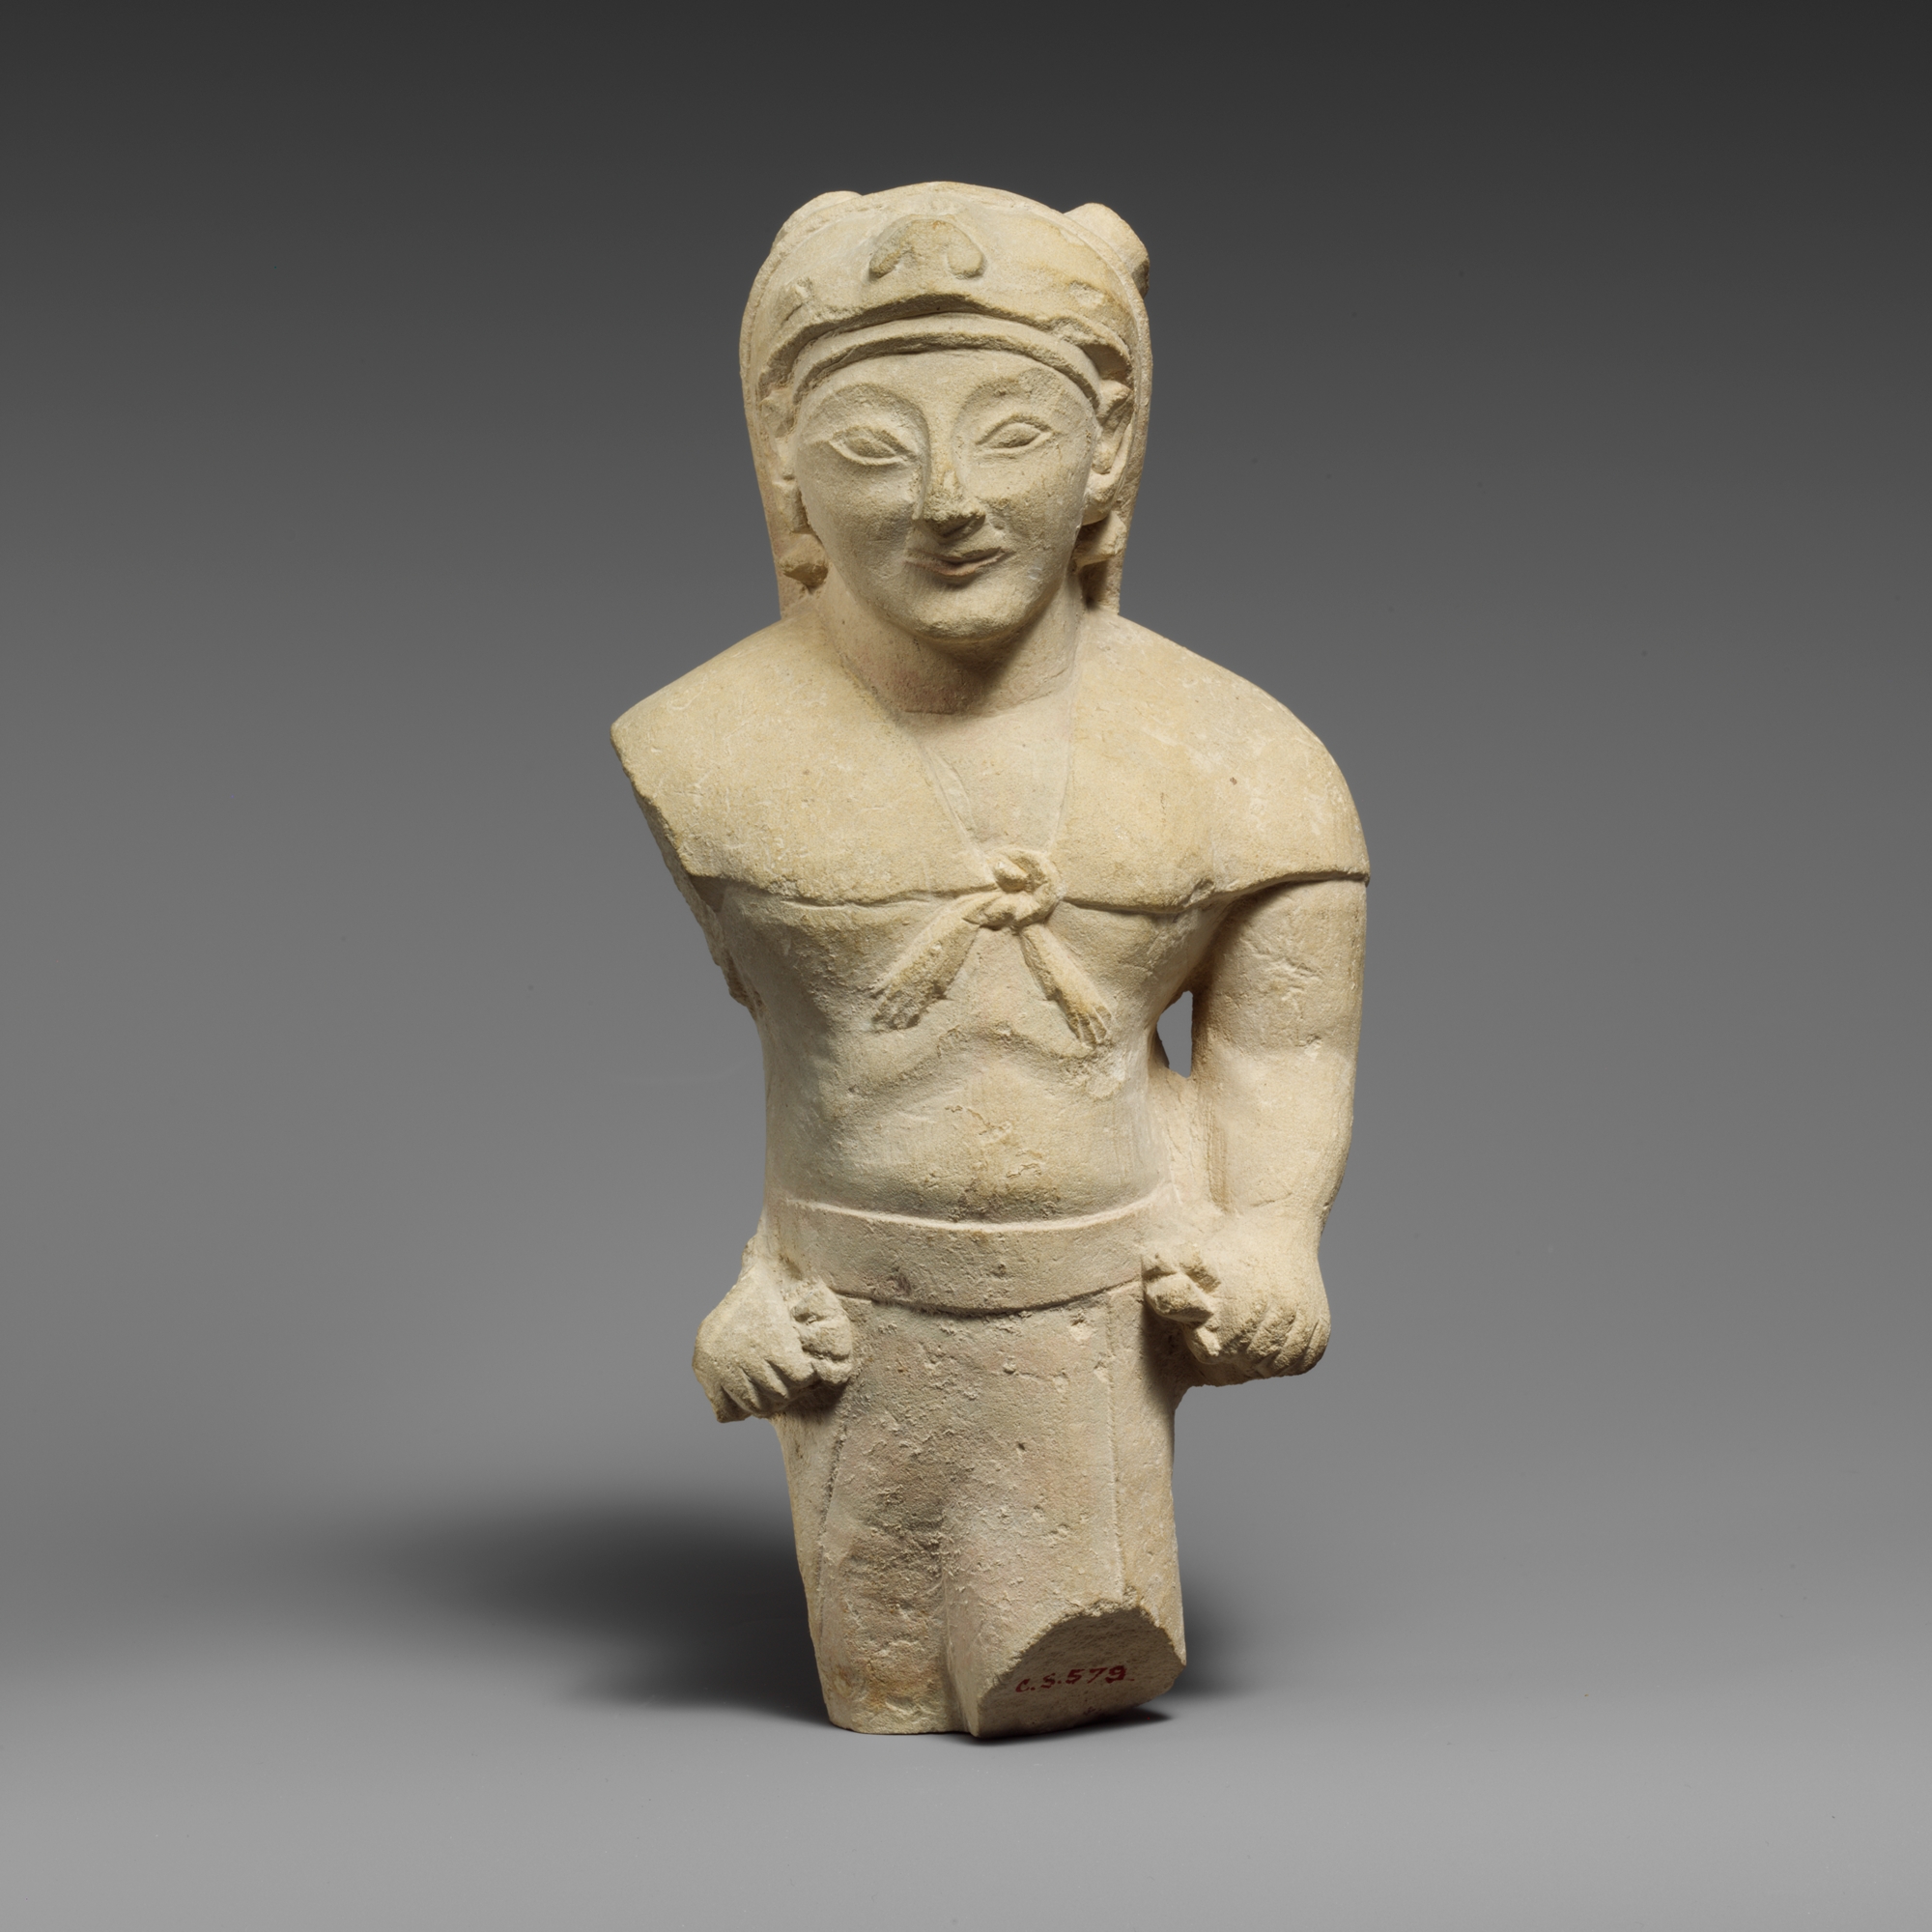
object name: statuette of herakles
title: Limestone statuette of Herakles as an archer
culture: cypriot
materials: limestone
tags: herakles